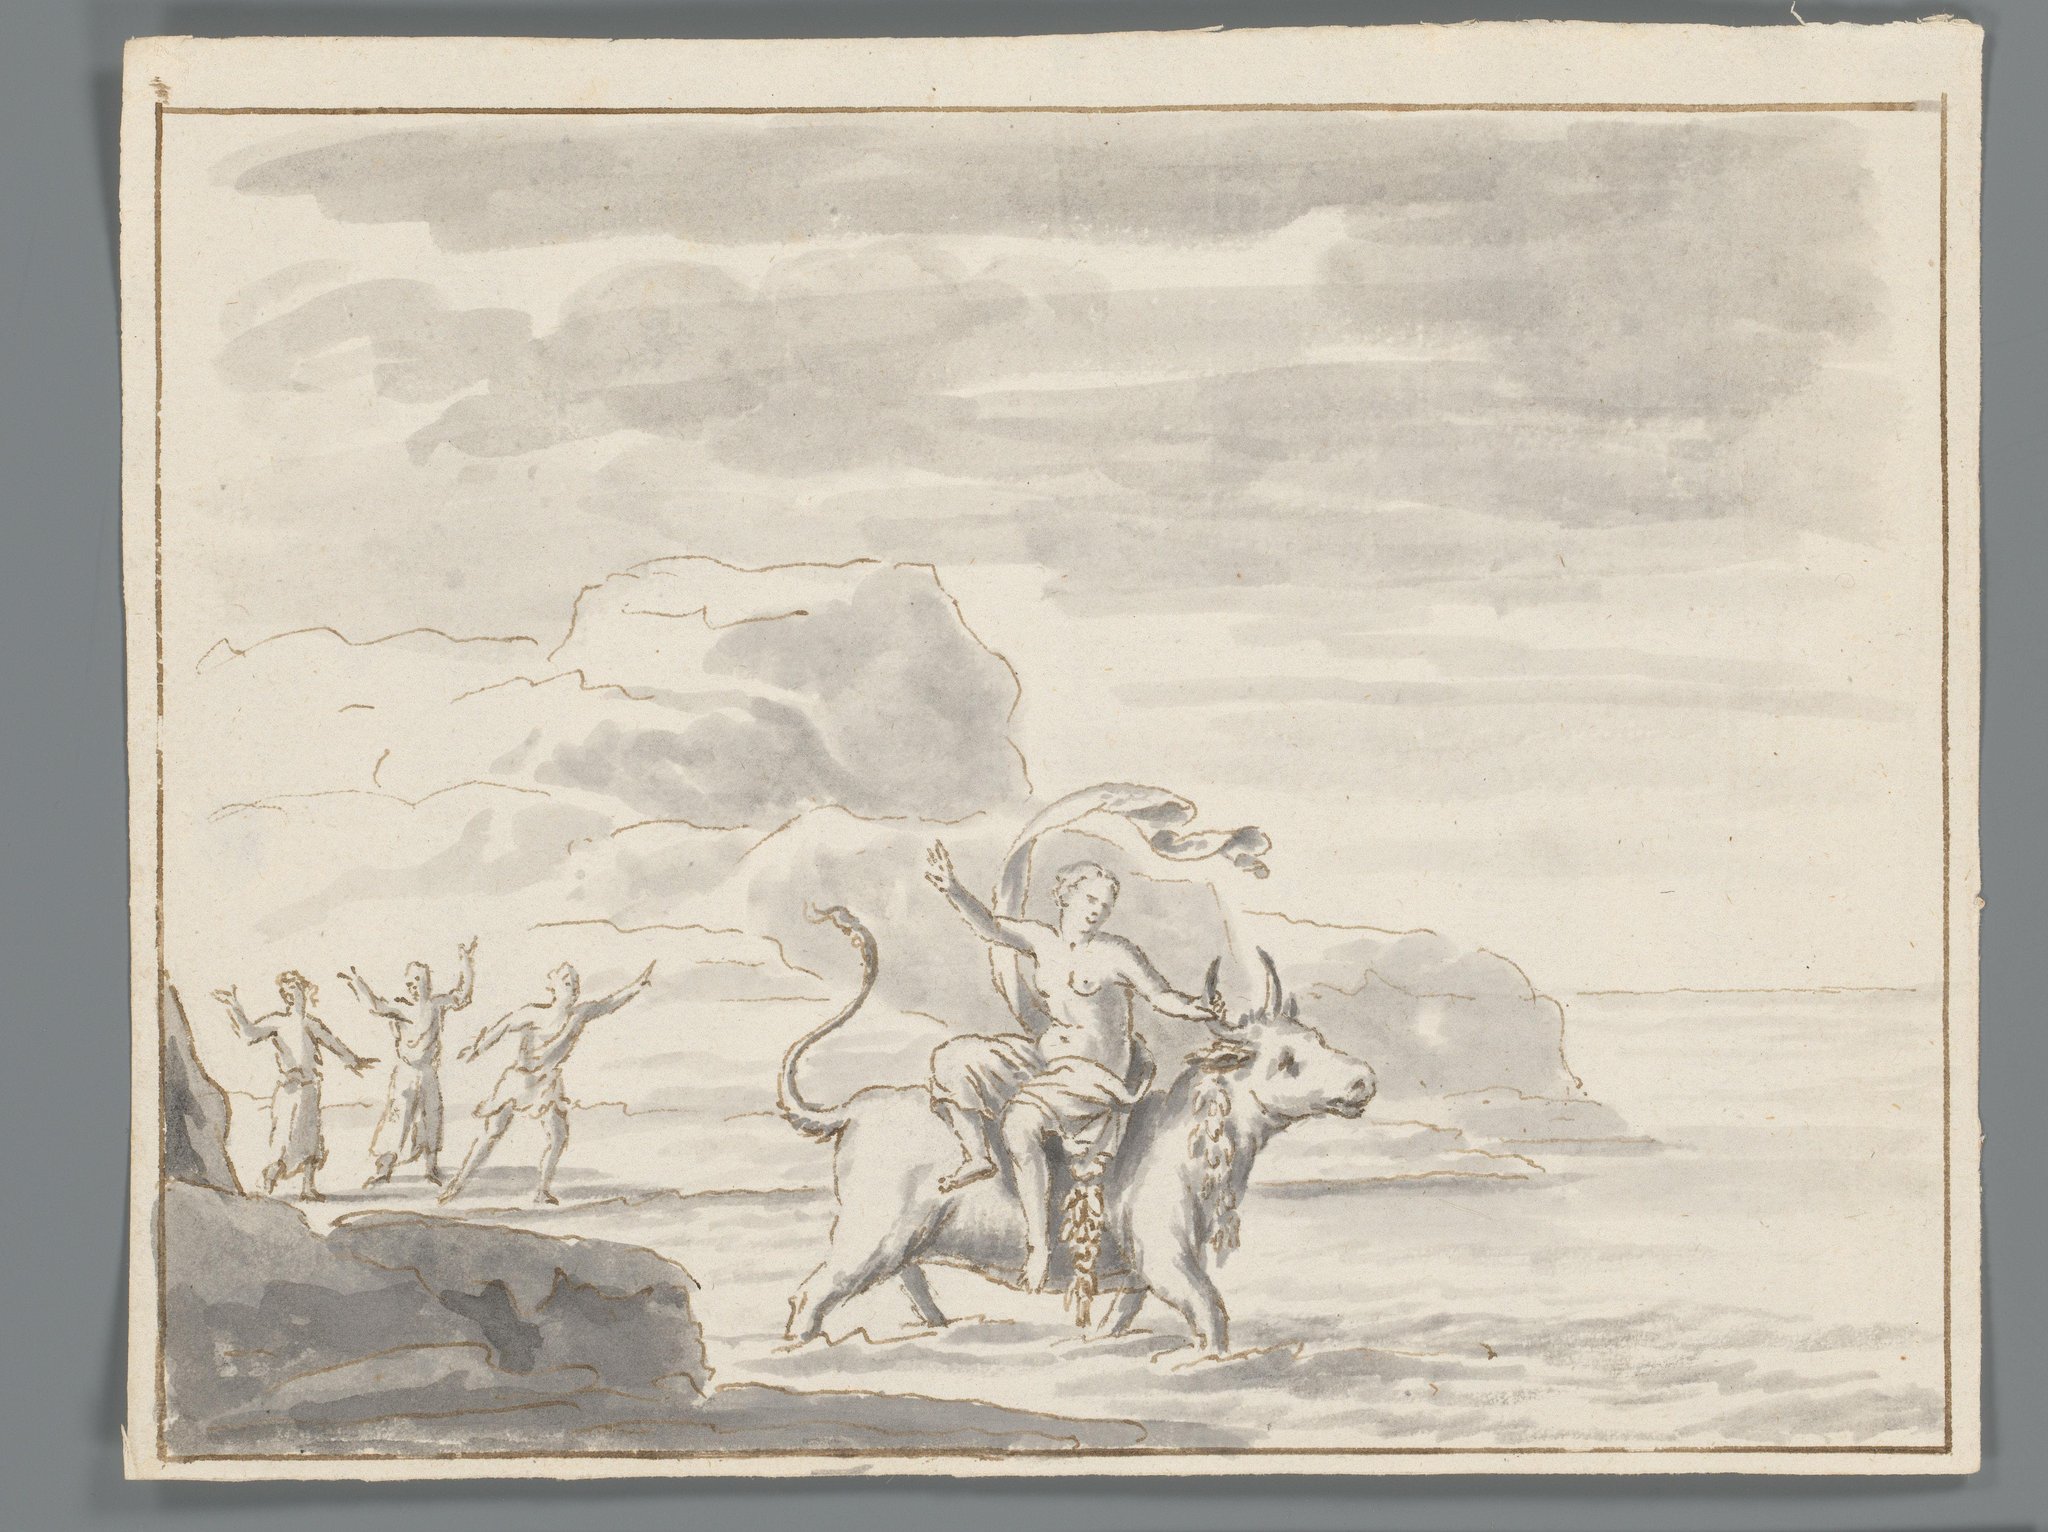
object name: drawing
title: Europa en de stier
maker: matthijs balen (1684-1766)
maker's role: draughtsman, painter, print maker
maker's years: 1684-1766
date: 1694-1766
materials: paper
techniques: brush, pen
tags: jupiter, usually in the shape of a white bull, abducts europa and carries her across the water